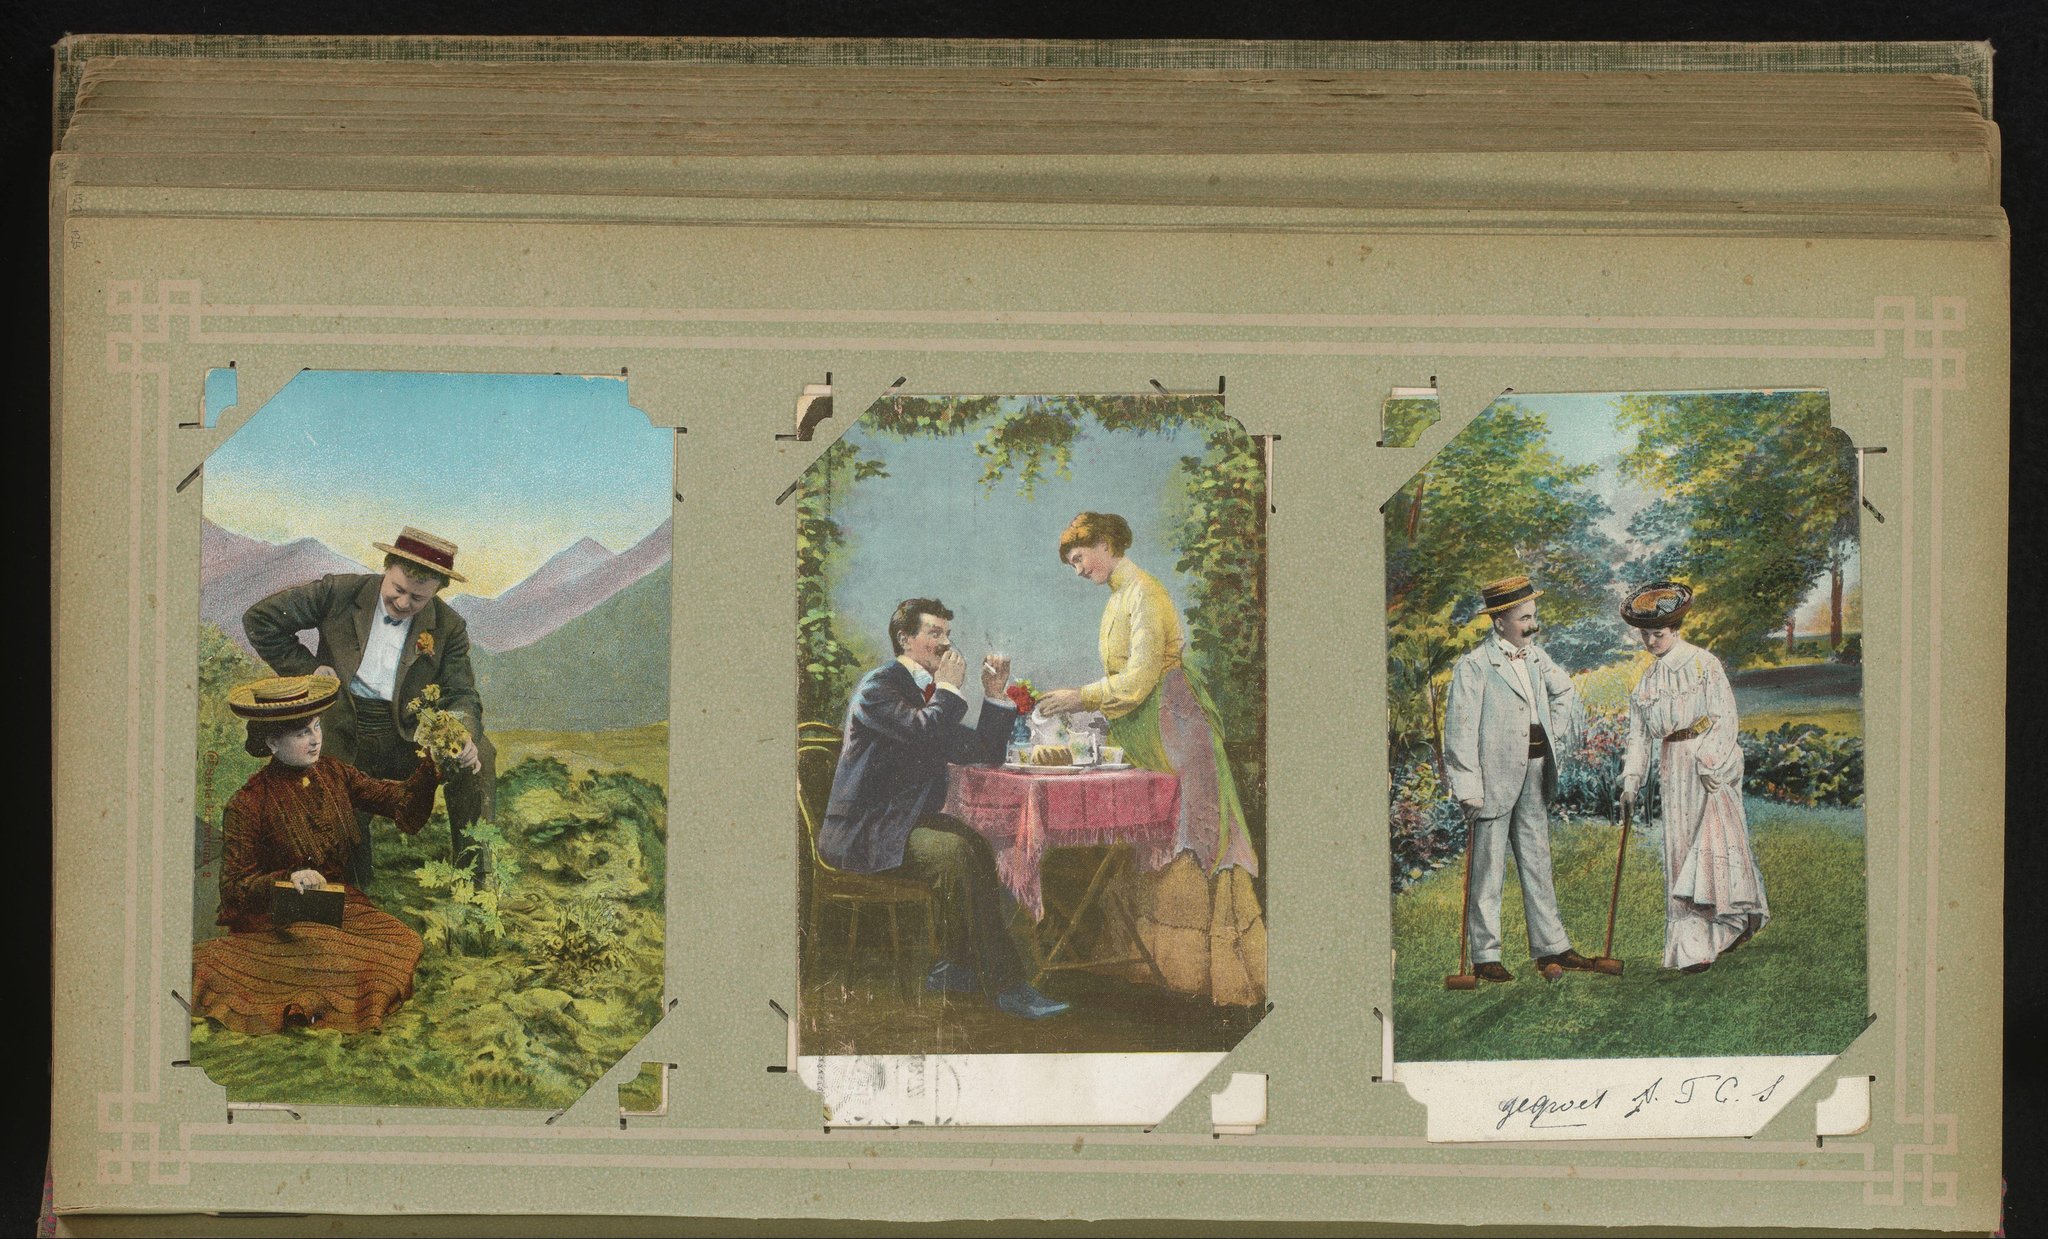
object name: photomechanical print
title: Drie portretten van een paar geliefden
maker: Anonymous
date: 1900-1930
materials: cardboard, ink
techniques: pen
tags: historical persons, golf, couple of lovers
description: Deze prenten maken deel uit van een album.